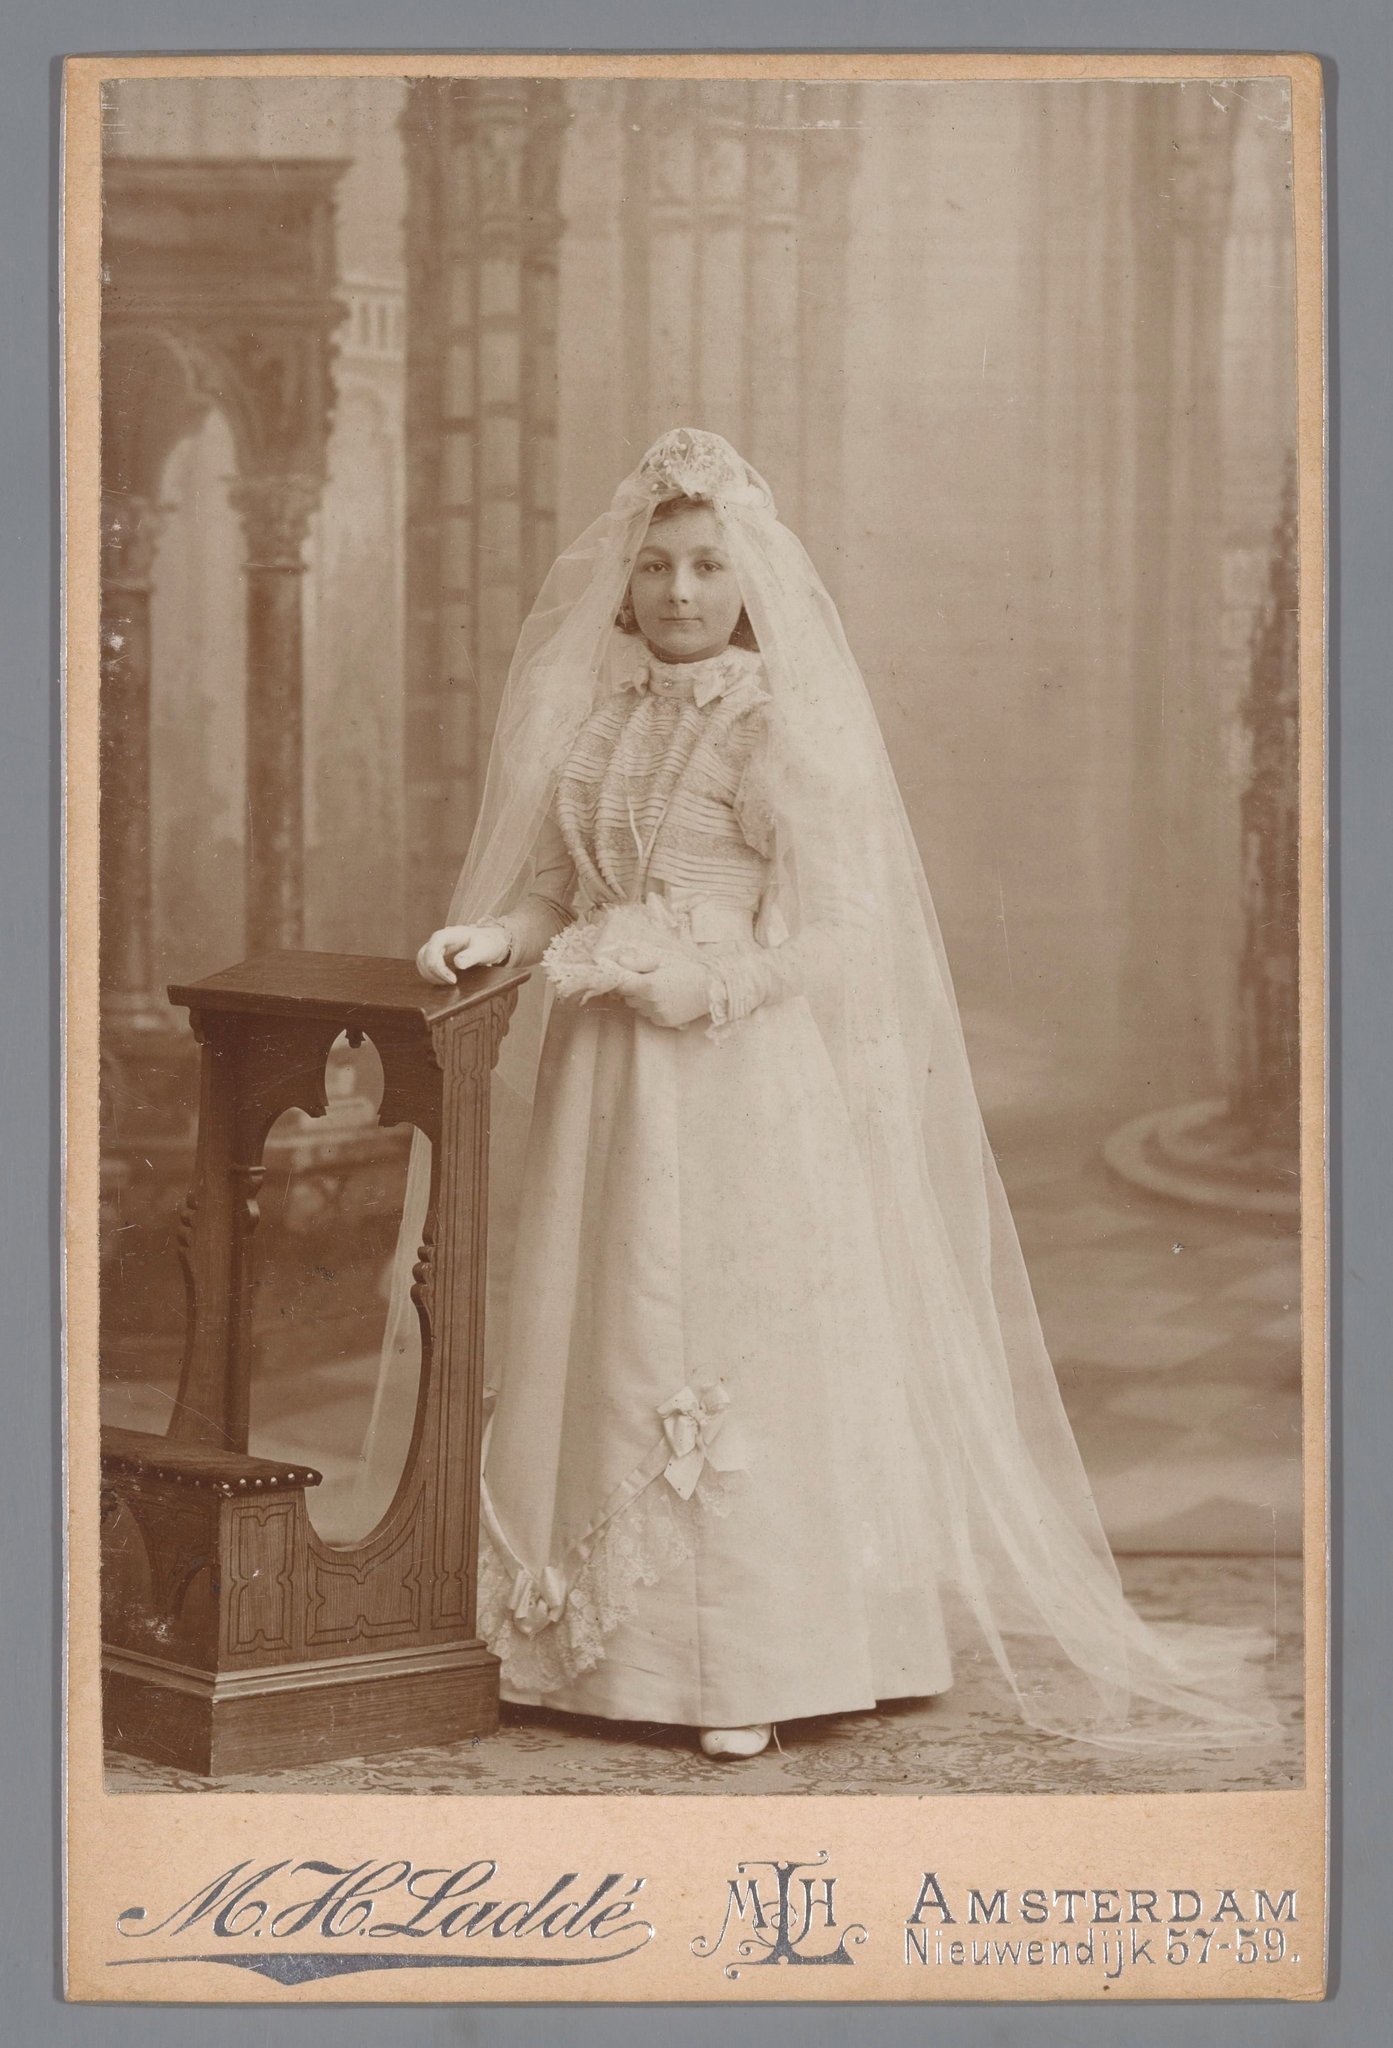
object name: photograph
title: Portret van een onbekend meisje in een communiejurk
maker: machiel hendricus laddé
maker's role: fotograaf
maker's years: 1866-1932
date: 1892-1906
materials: cardboard, photographic support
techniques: collodion silver print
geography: amsterdam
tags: studio requisites ~ photographer, first communicant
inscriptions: name: ‘Photographie Artistique M.H. Laddé boven de Firma Merkelbach & co Amsterdam Nieuwendijk 57-59. (...)’